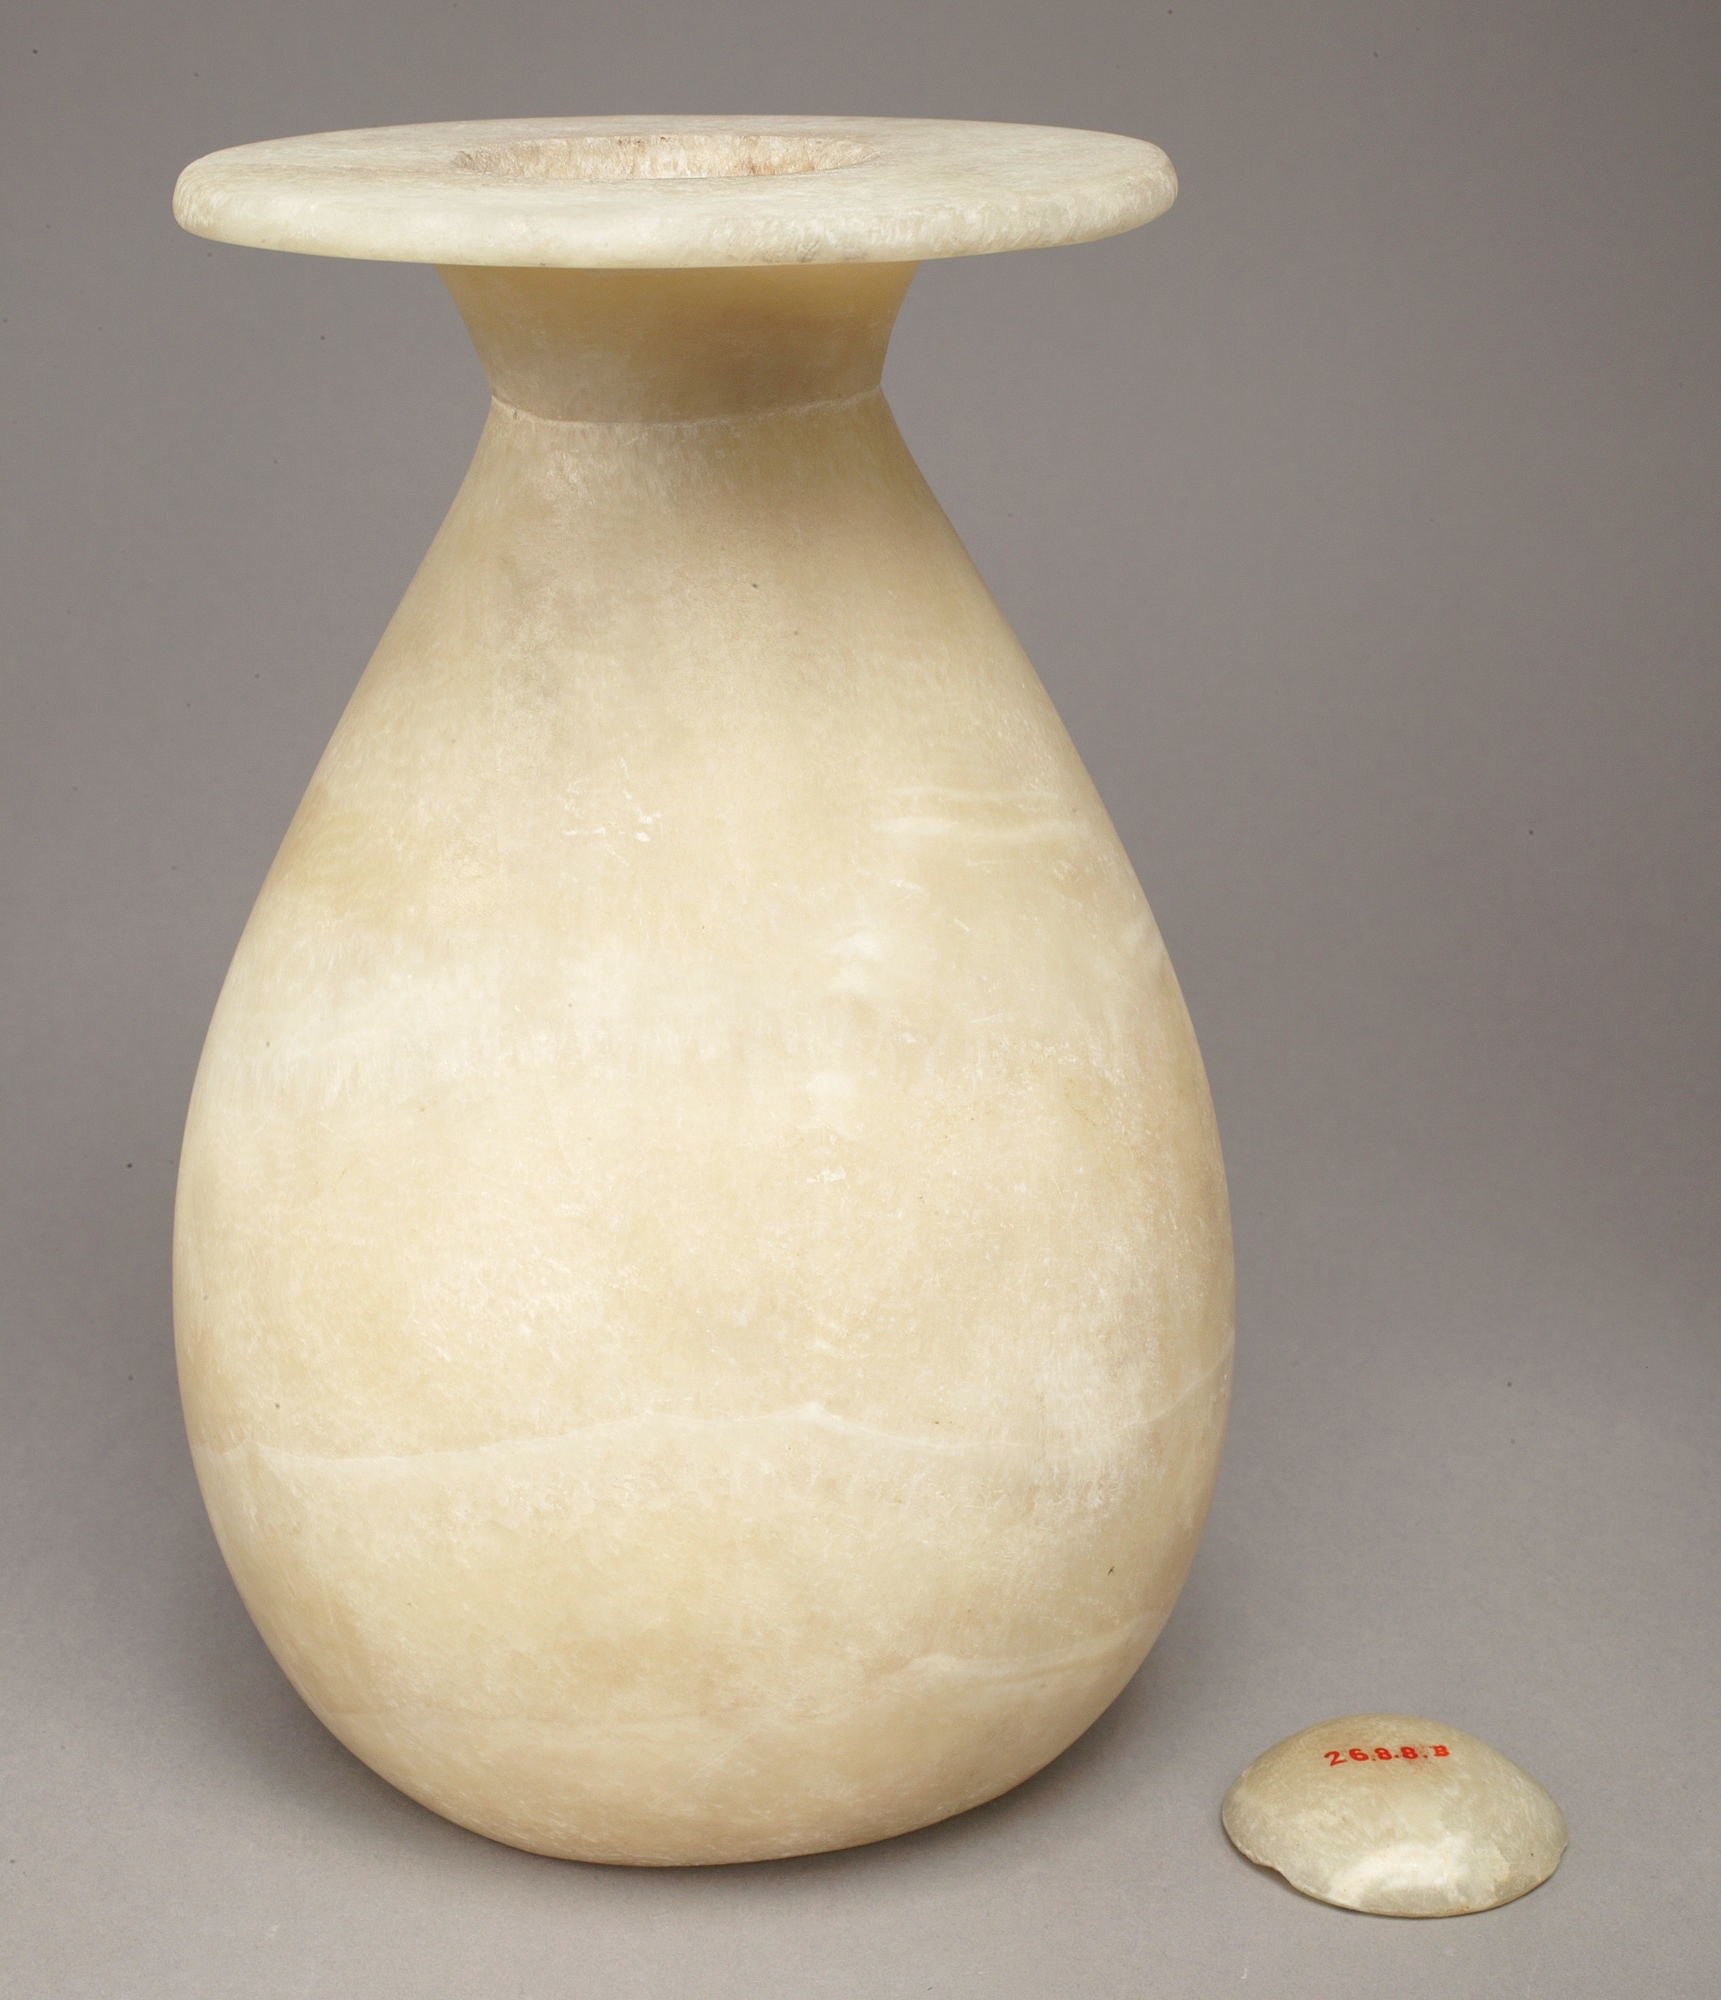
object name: jar with lid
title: Jar lid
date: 1492-1479 BCE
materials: stone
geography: upper egypt, thebes